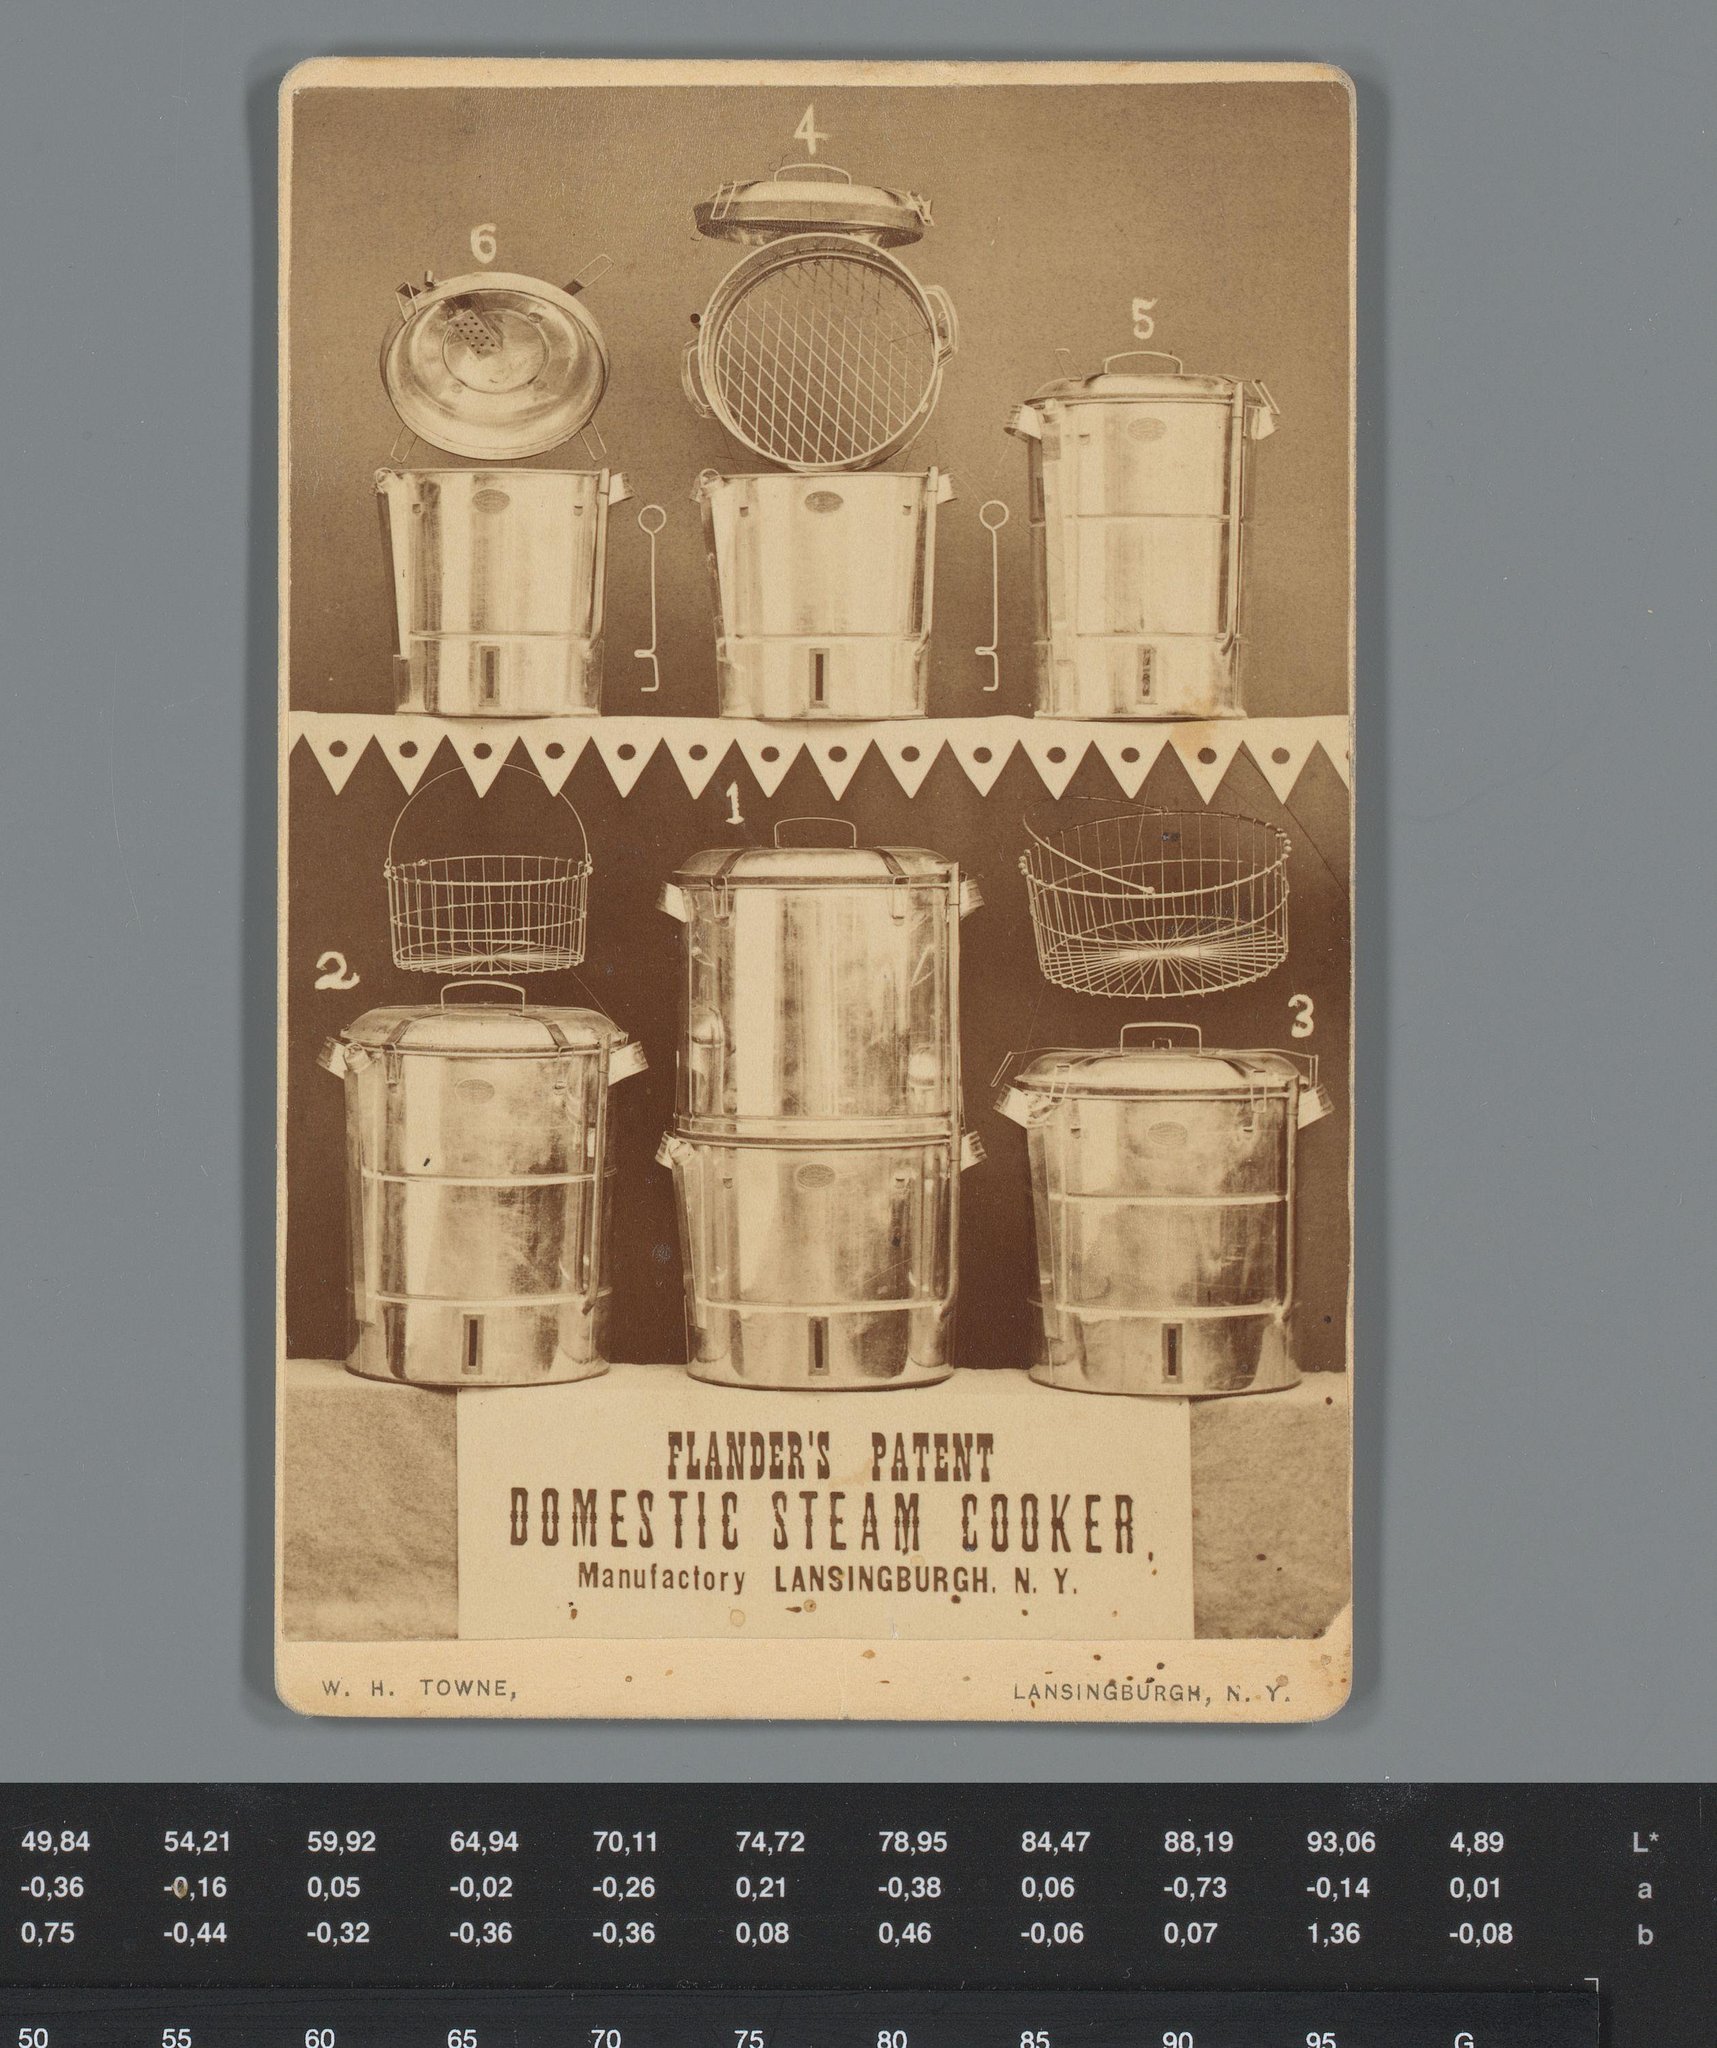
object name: cabinet photograph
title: Zes kookpotten van Flander's Patent Domestic Steam Cooker Manufactury in Lansingburgh, New York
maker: towne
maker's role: fotograaf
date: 1860-1900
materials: cardboard, photographic support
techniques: albumen print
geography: new york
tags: cooker, kitchen-utensils: pot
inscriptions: inscription: ‘Wilke Wilke Briss’, inscription: ‘W.H. Towne, LANSINGBURGH, N.Y.’